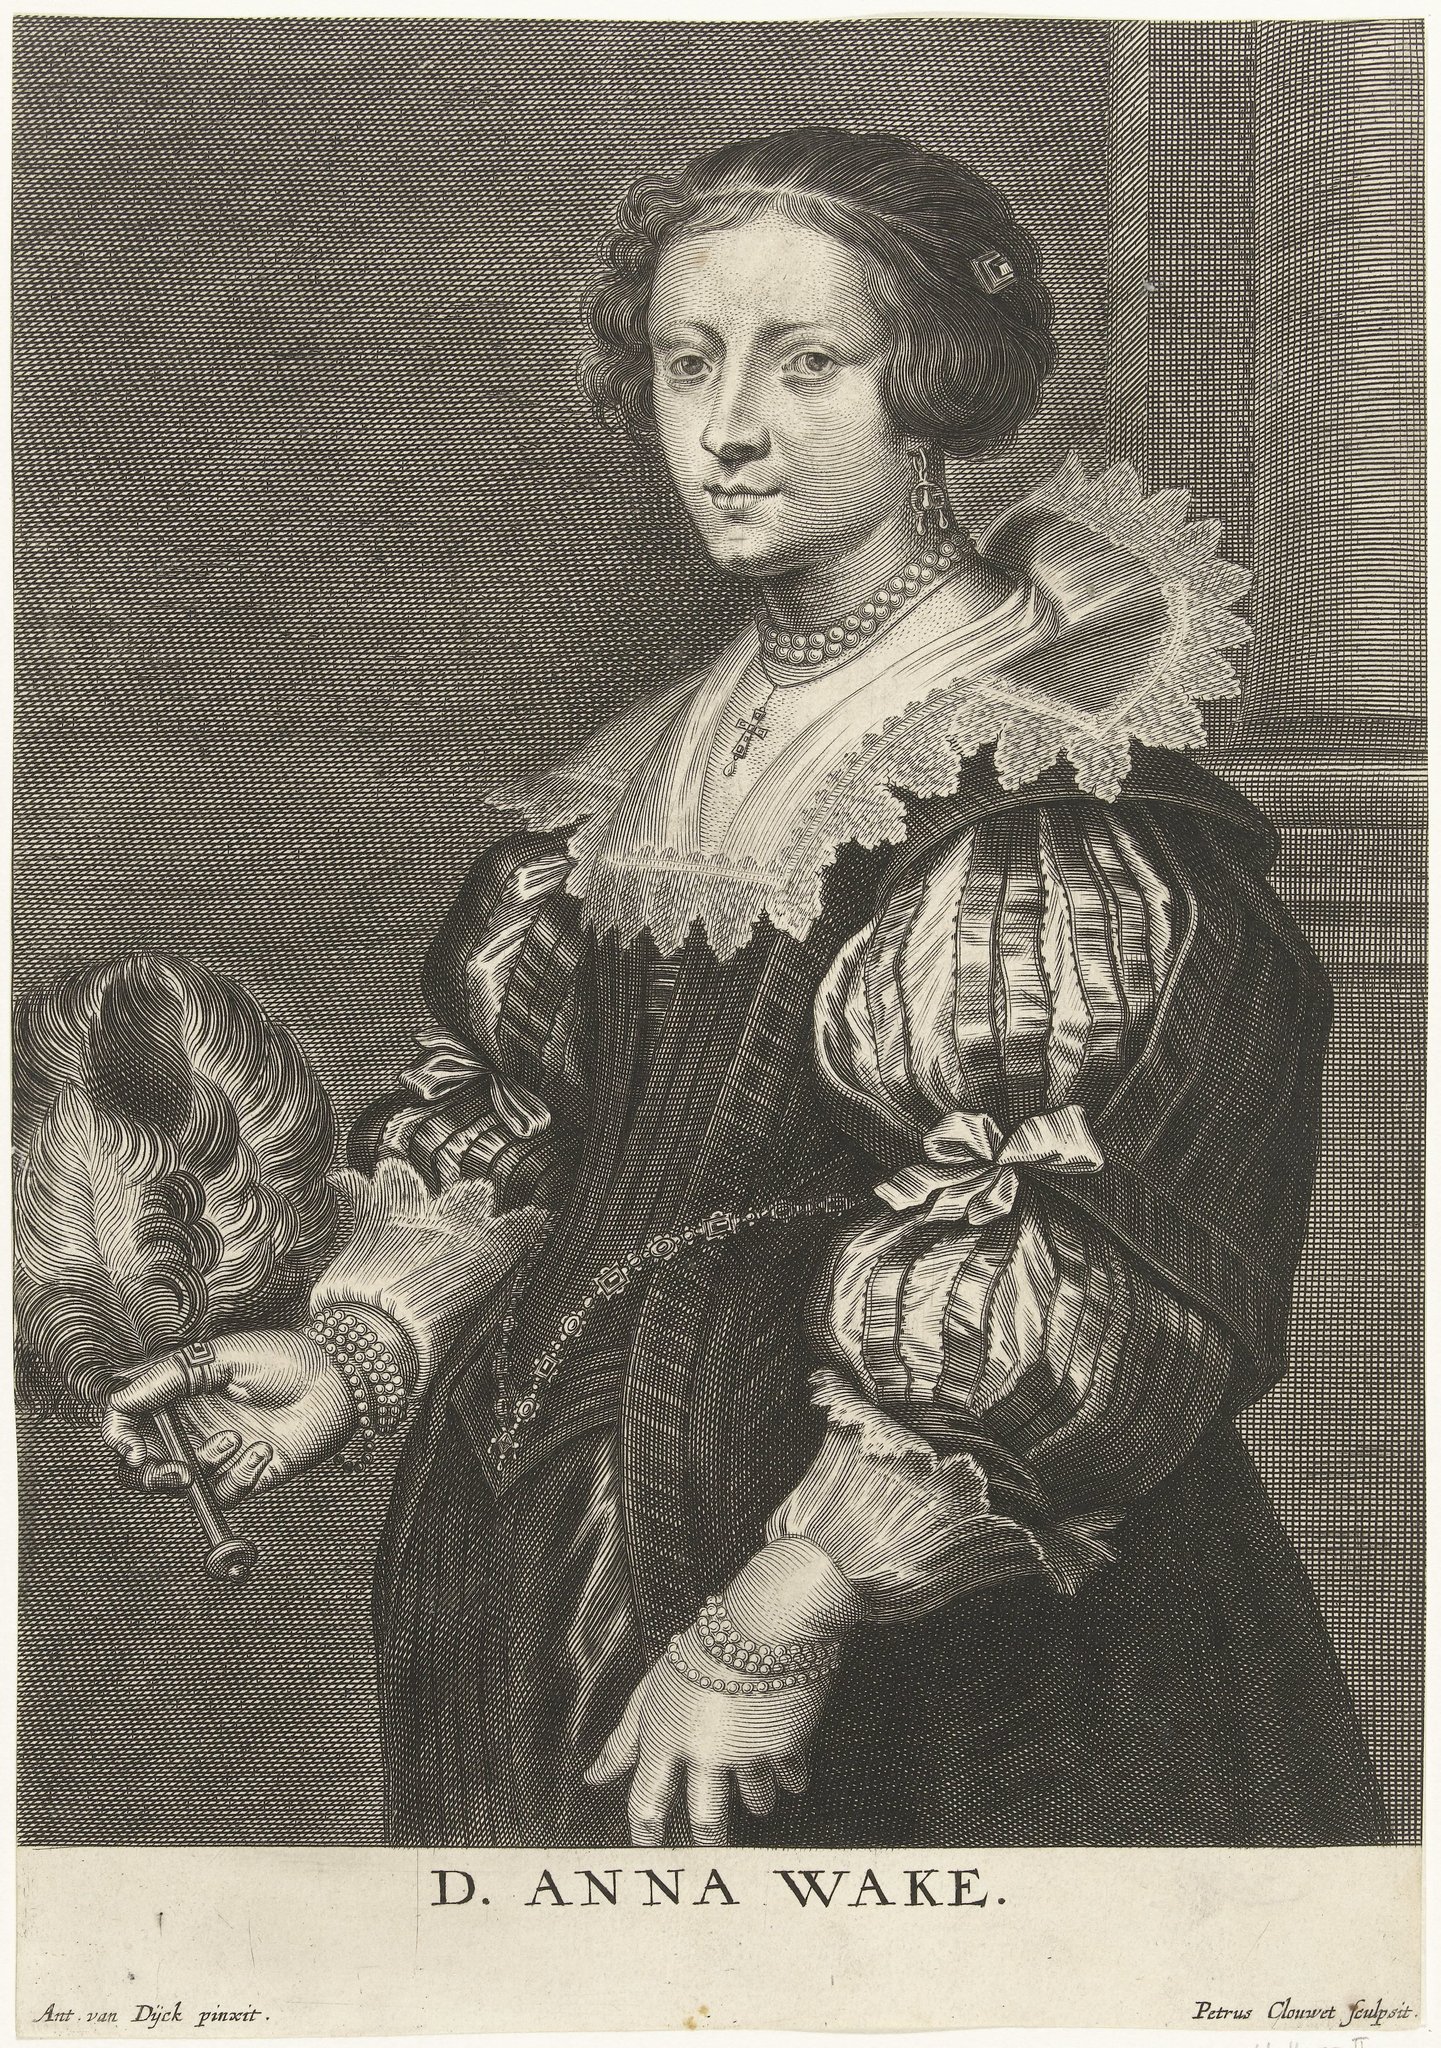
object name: print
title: Portret van Anna Wake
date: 1639-1670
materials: paper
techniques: engraving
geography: antwerp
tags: anna wake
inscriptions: collector's mark: Lugt 240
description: Portret van Anna Wake, de vrouw van de Antwerpse koopman Peeter Stevens. Buste naar links. Anna Wake is rijkelijk gekleed en heeft een waaier in de rechterhand.